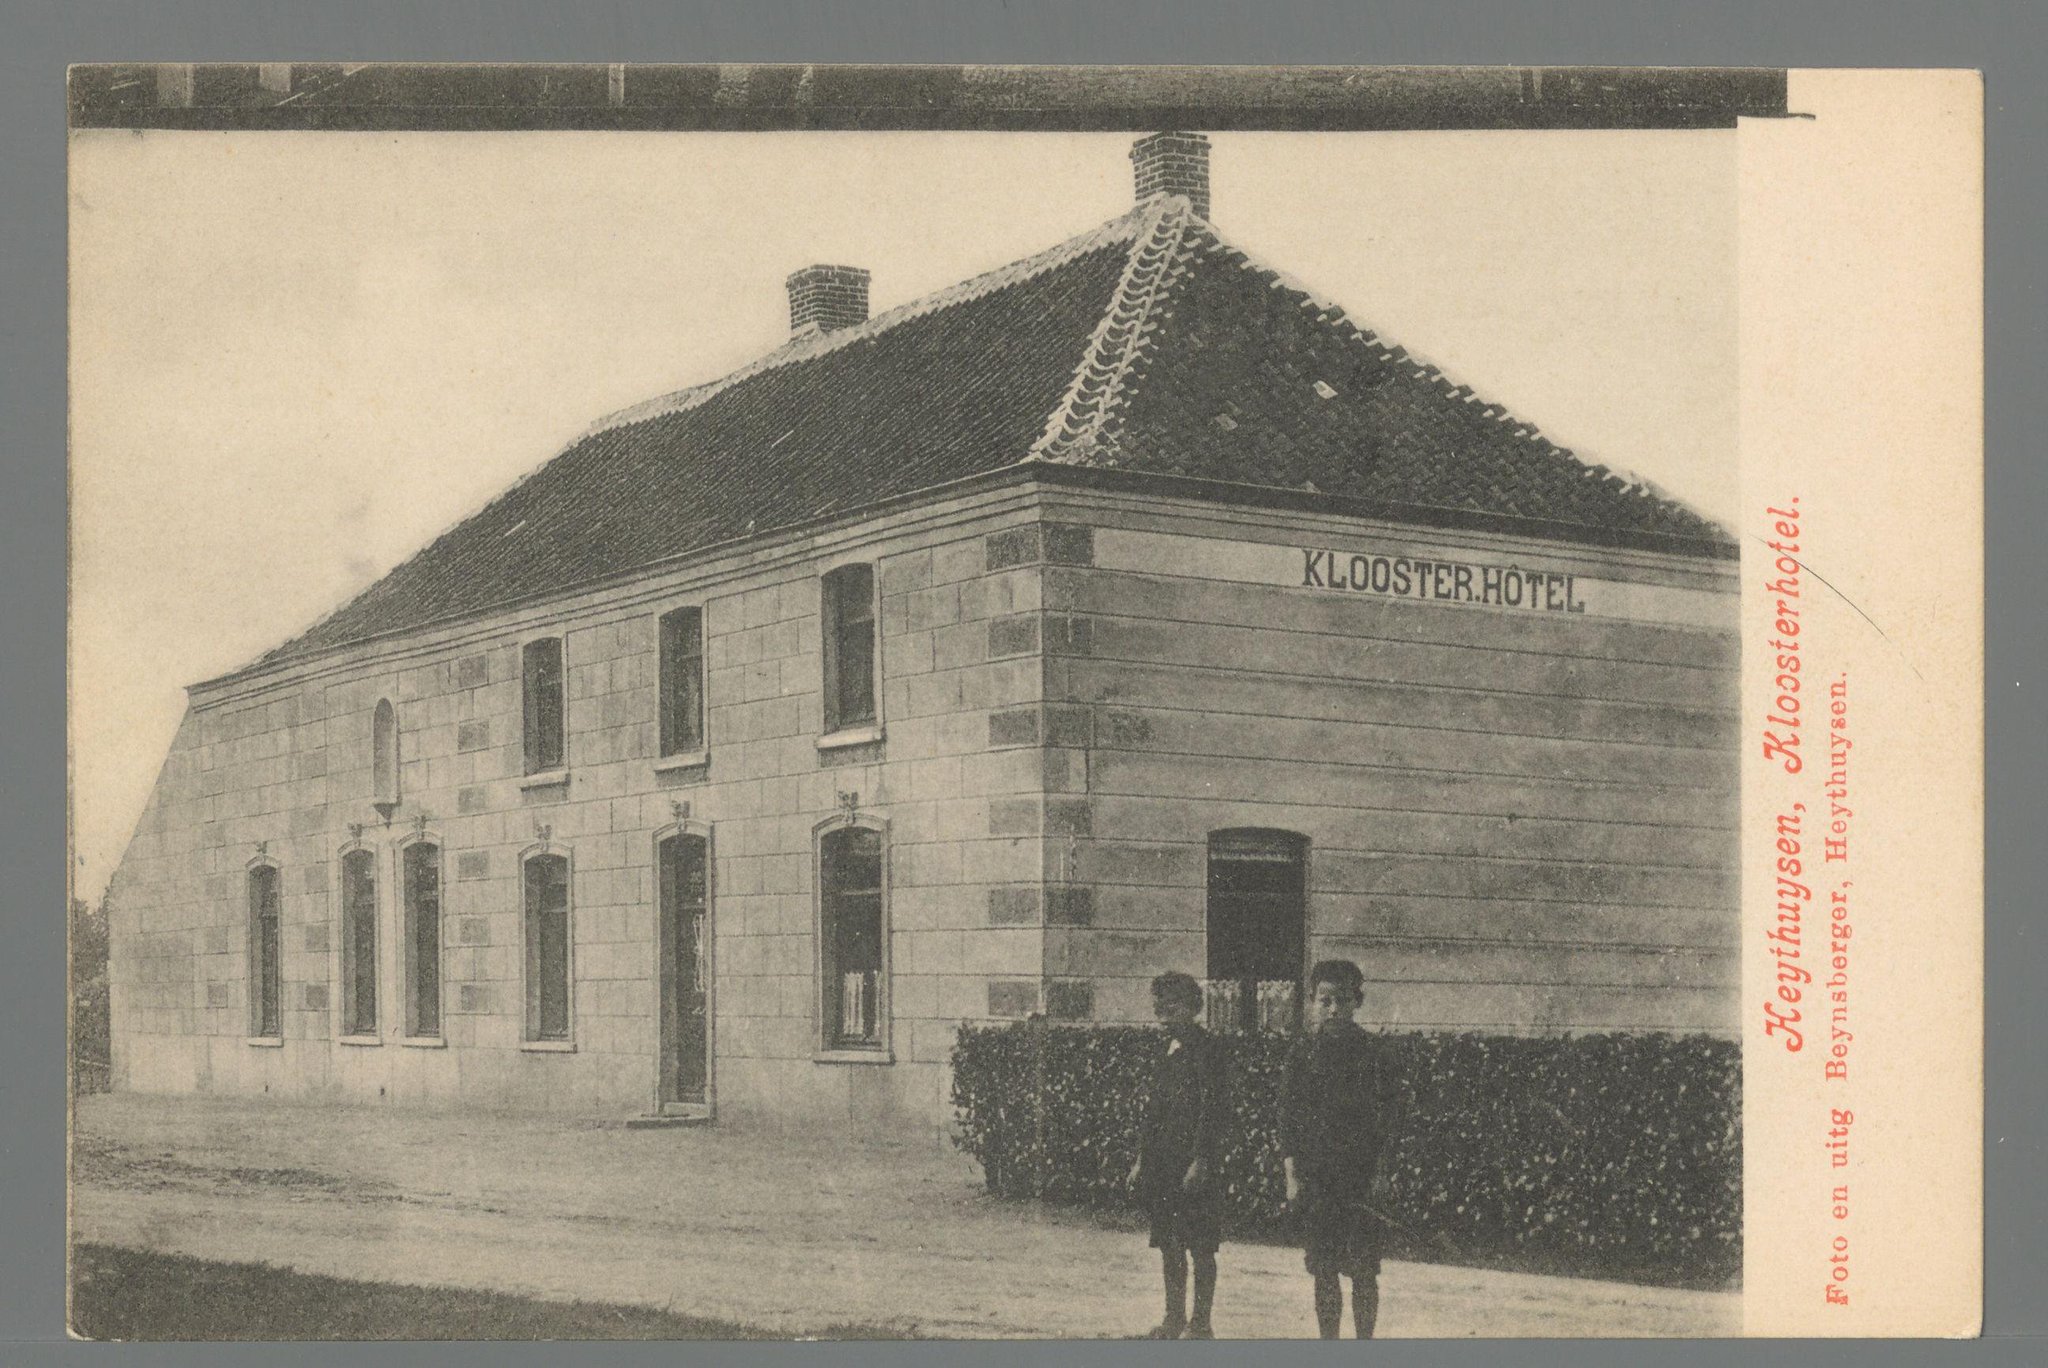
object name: ansichtkaart, prentbriefkaart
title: Heythuysen, Kloosterhotel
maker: Anonymous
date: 1905-1930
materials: cardboard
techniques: photograph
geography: heythuysen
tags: hotel, hostelry, inn